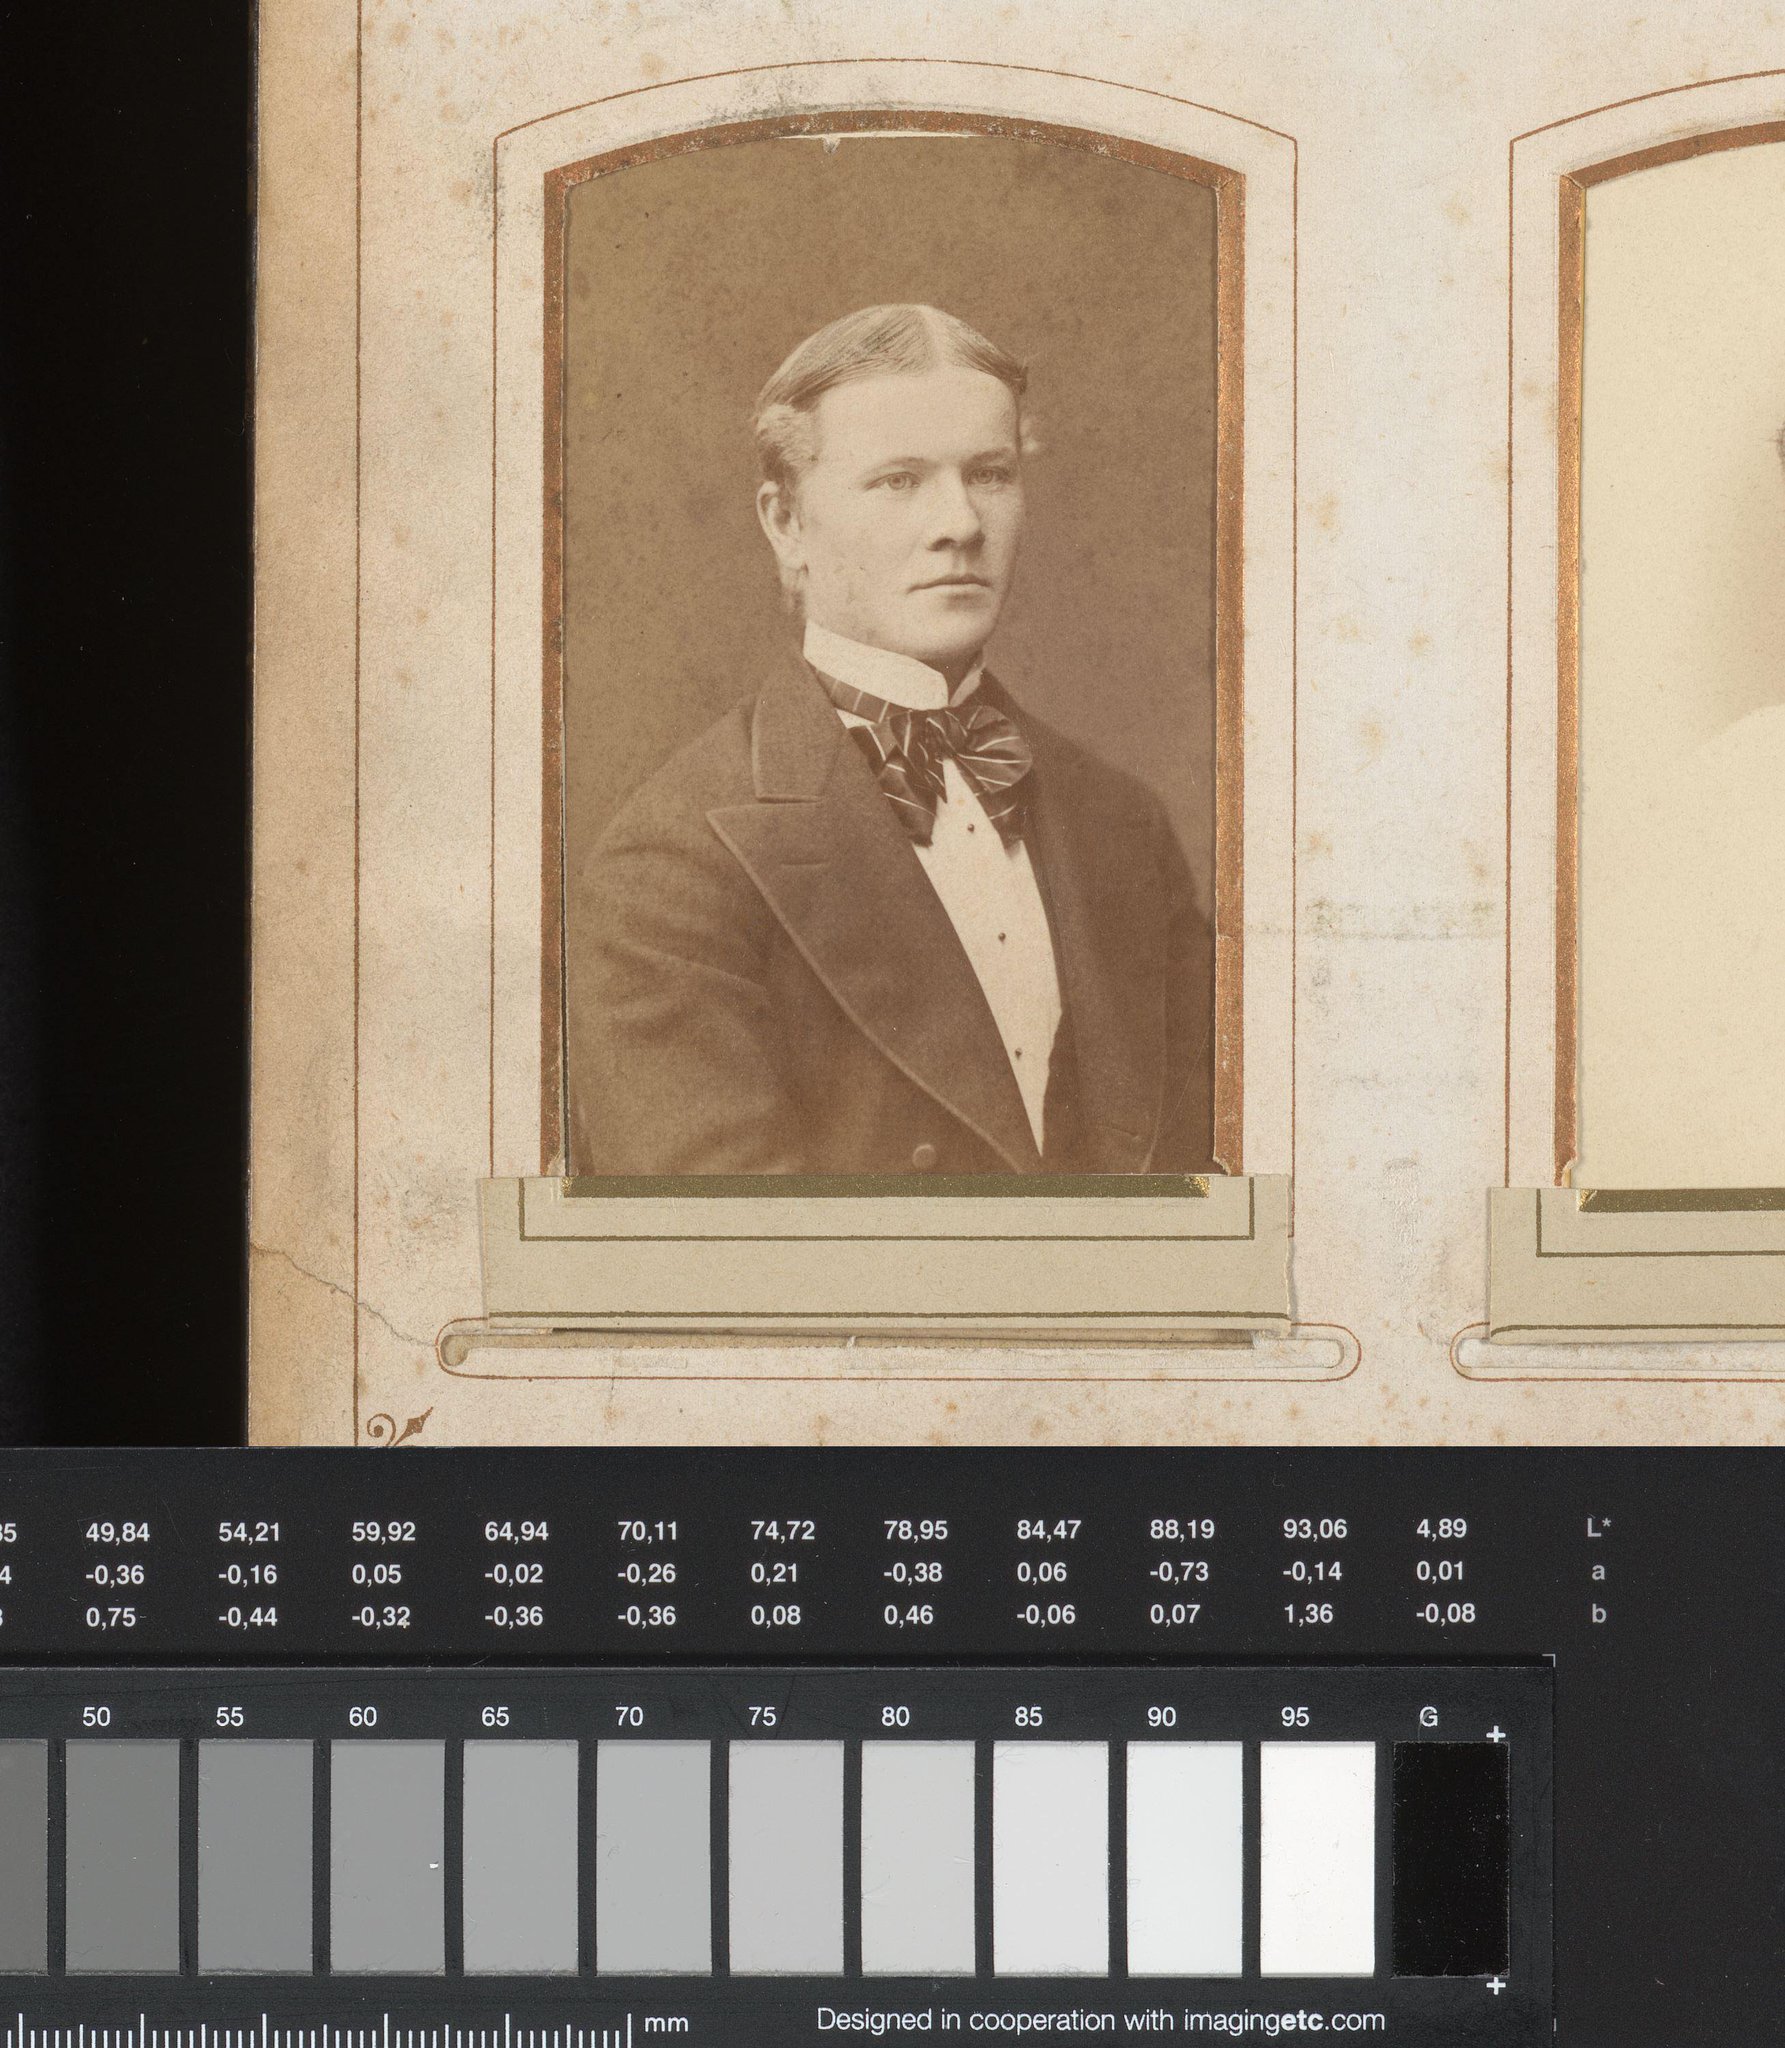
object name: album leaf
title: Portret van een jonge man met vlinderstrik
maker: august roesler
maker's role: fotograaf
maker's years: 1837-1896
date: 1860-1896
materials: cardboard, photographic support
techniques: albumen print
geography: stockholm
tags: historical persons, youth, adolescent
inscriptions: inscription: ‘Robert Roesler's/ Fotografi-Atelier/ STOCKHOLM/ 38, Stora Nygatan 38./ Plåten förvaras för efterbeställning.’